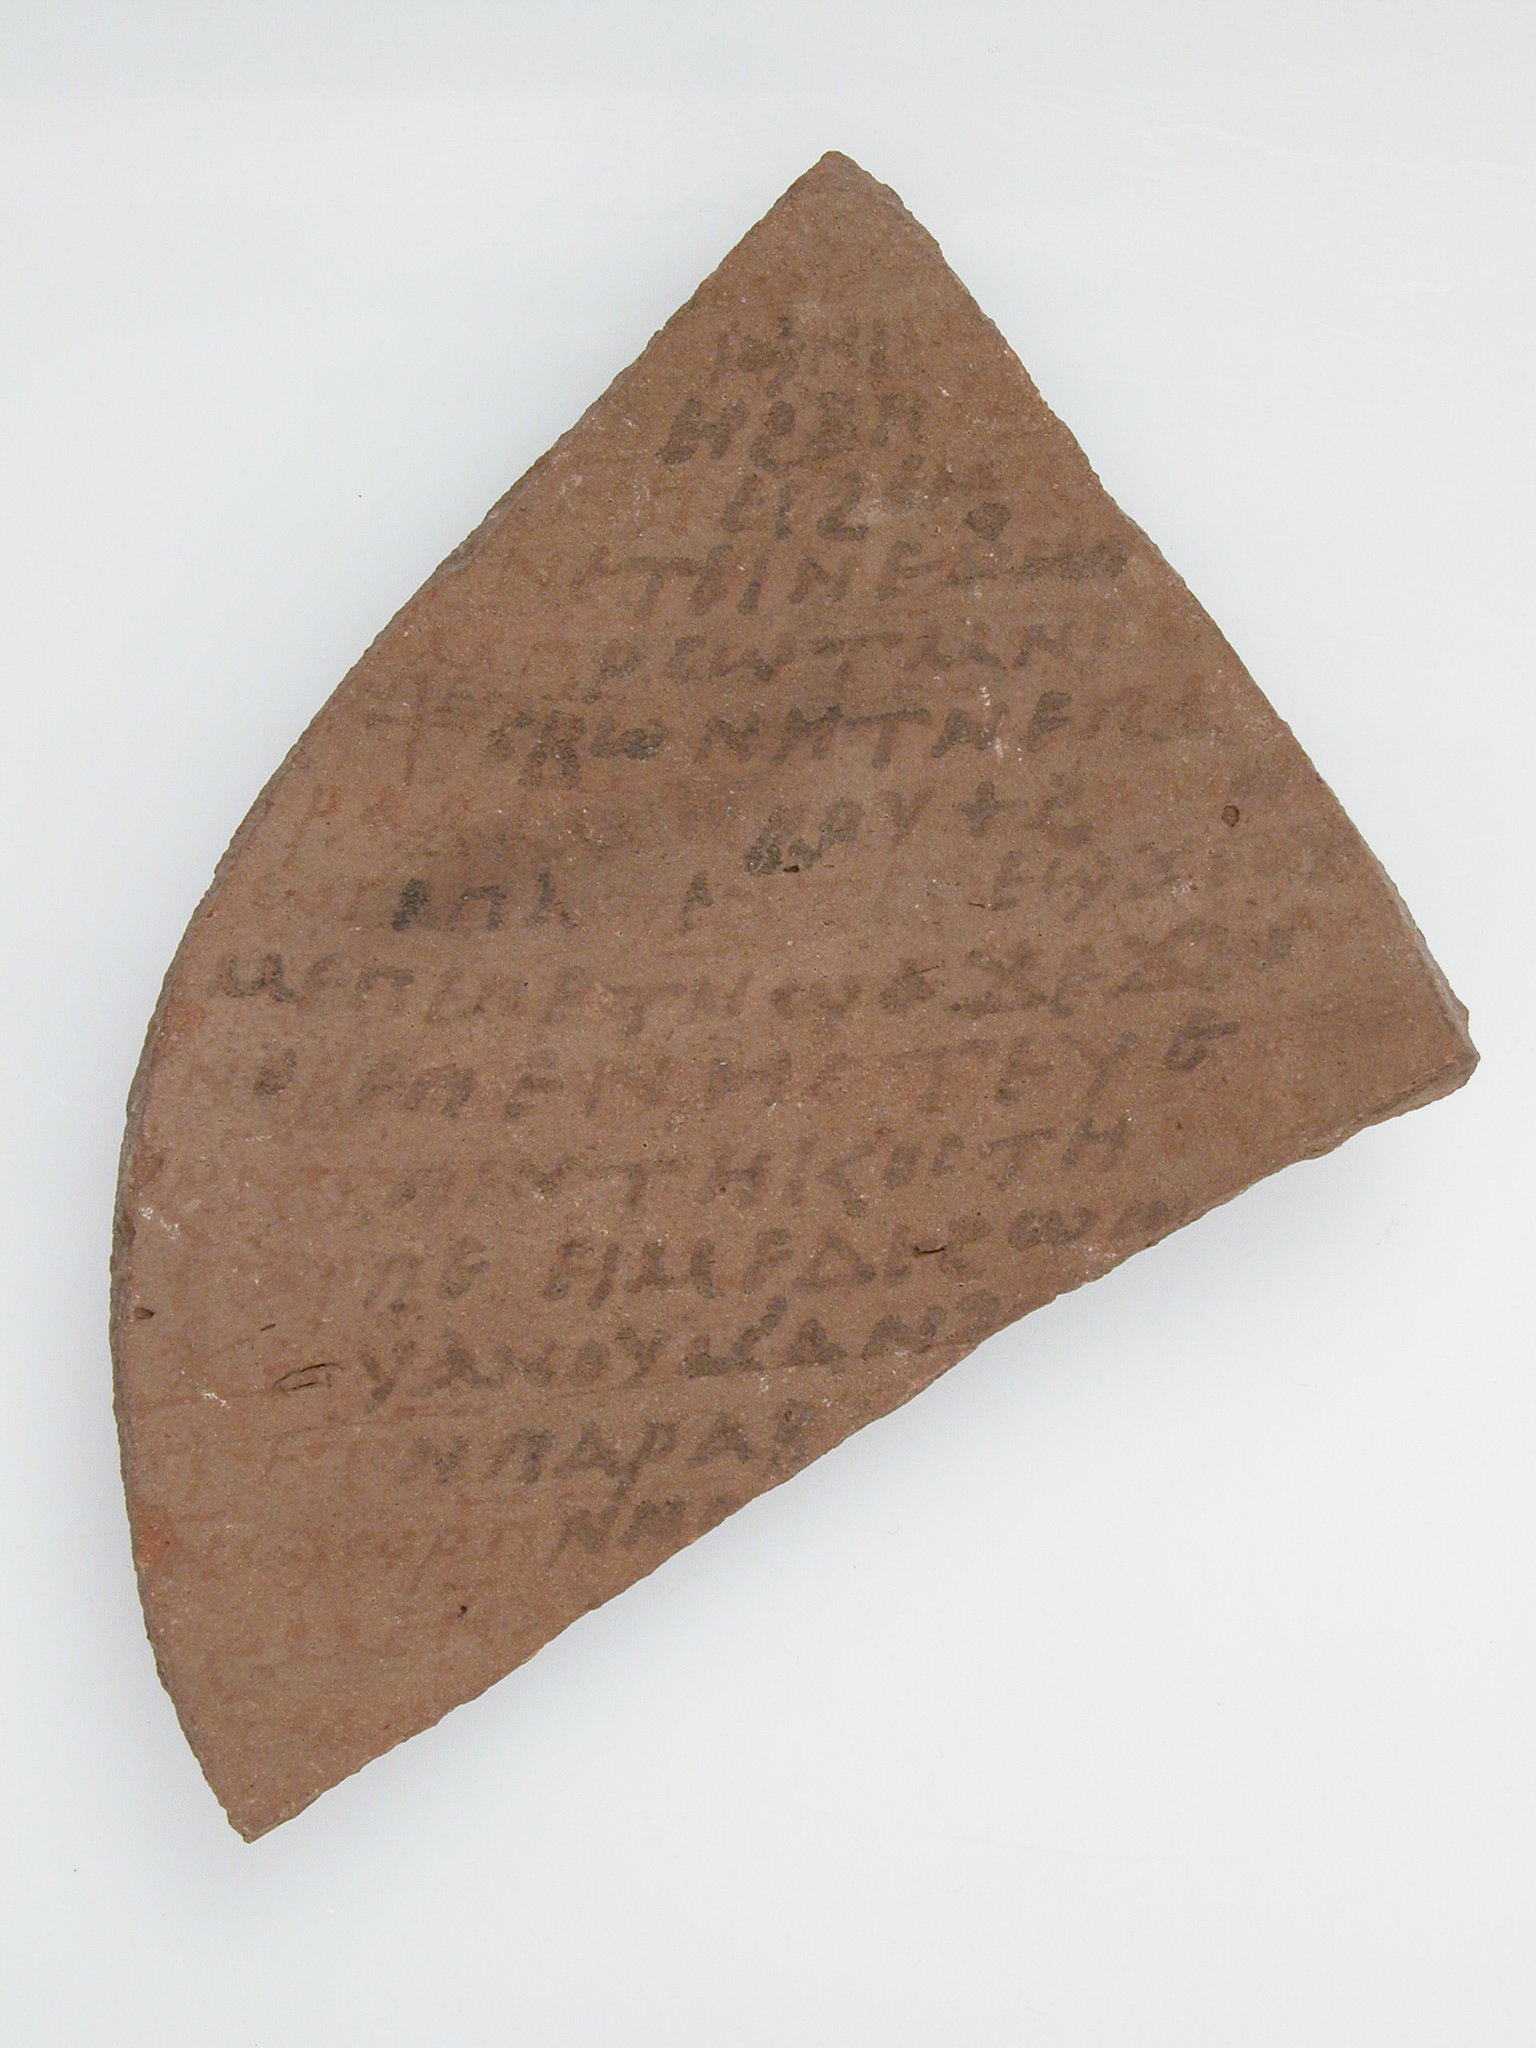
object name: ostrakon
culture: coptic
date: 601-700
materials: ink, pottery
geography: egypt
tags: documents